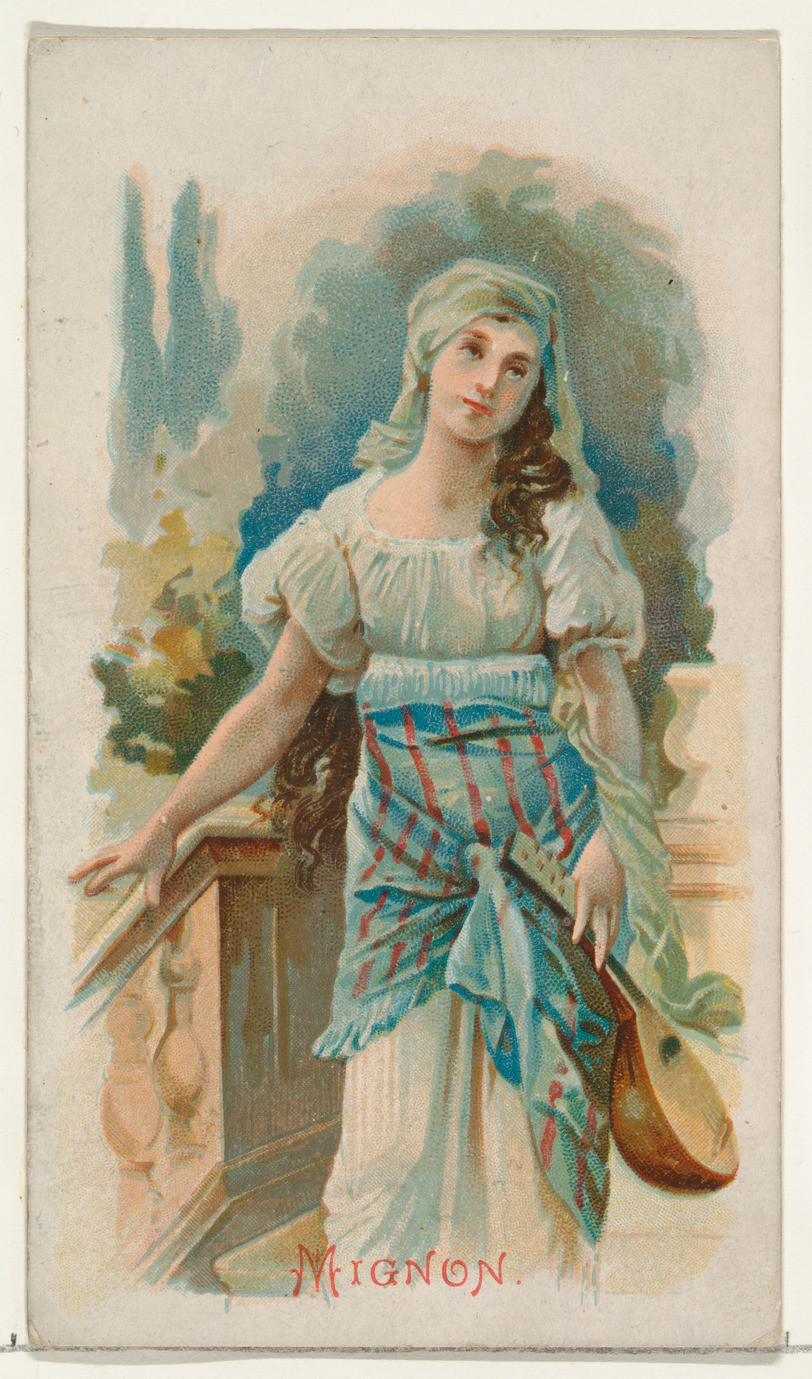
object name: print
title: Mignon, from the Illustrated Songs series (N116) issued by W. Duke, Sons & Co. to promote Honest Long Cut Tobacco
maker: w. duke, sons & co.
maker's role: publisher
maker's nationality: american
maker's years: 1870-1920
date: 1893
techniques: color lithograph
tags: musical instruments,women